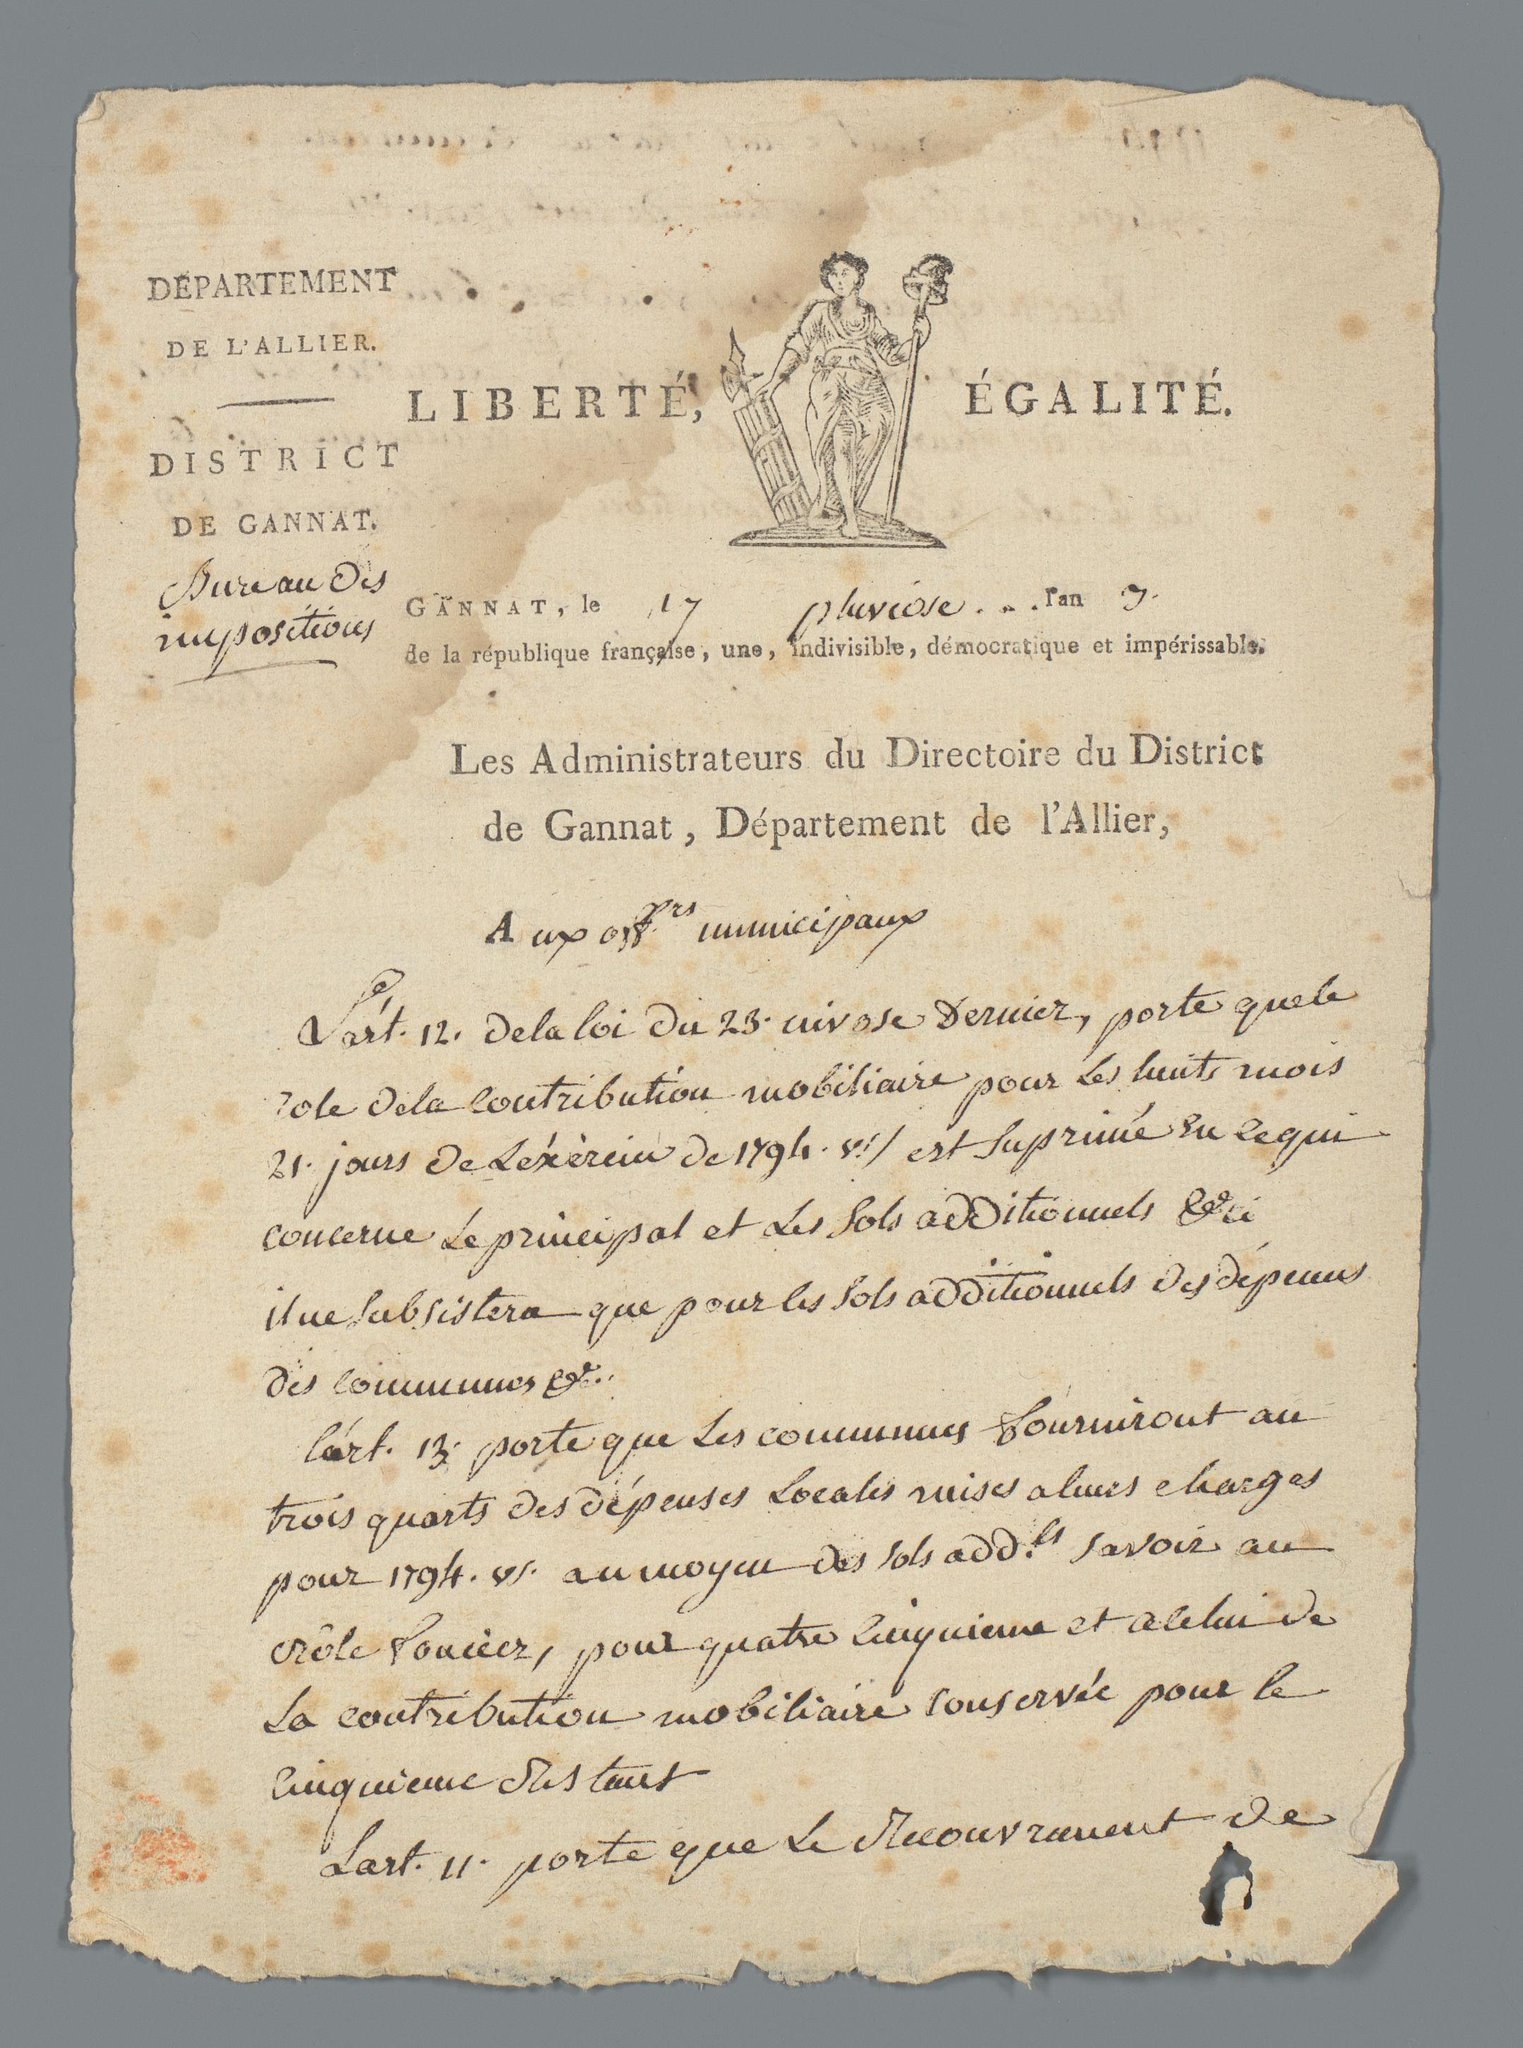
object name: manuscript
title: Brief van 'Les Administrateurs du Directoire du District de Gannat, Département de l'Allier', 17 januari 1793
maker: Anonymous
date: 1793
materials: paper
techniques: handwriting, letterpress printing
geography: france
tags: personifications of countries, nations, states, districts, etc.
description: Handgeschreven brief in voorgedrukt blad van 'Les Administrateurs du Directoire du District de Gannat, Département de l'Allier', 17 pluviôse (januari), jaar 1 (1793). Blad beschreven op beide zijden met pen in bruin. In de tekst worden de jaren 1793 en 1794 vermeld. Briefhoofd met vignet in houtsnede van de Franse Maagd 'Liberté Égalité'.